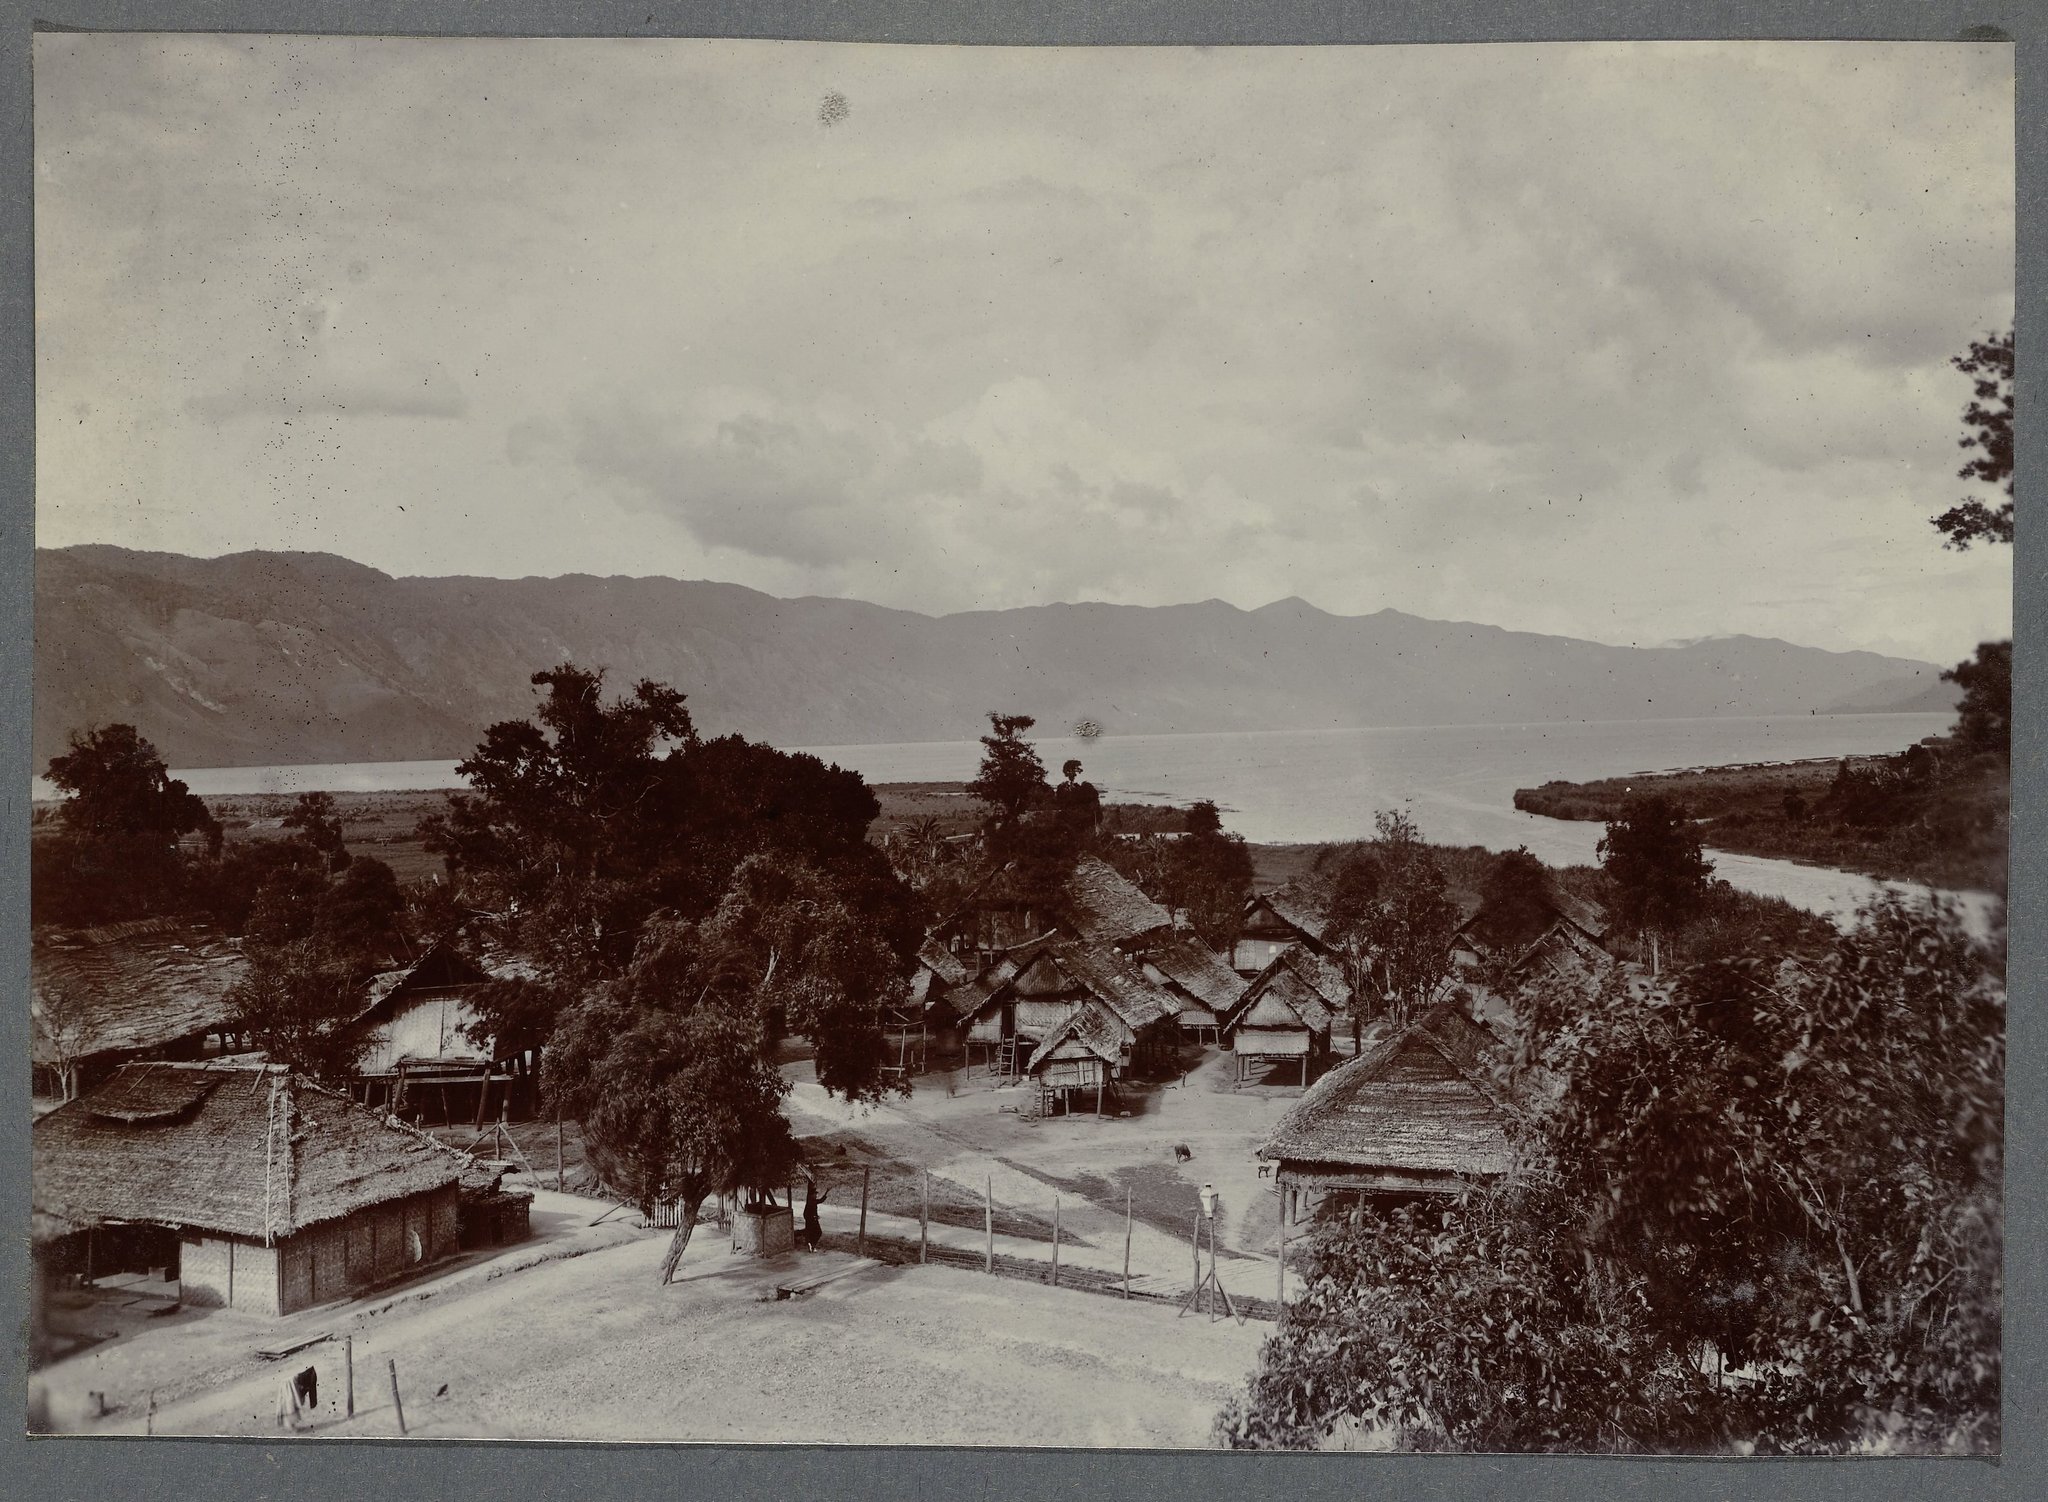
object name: photograph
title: Takengon aan het meer Laut Tawar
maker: Anonymous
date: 1903-1913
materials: photographic support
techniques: gelatin silver print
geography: north sumatra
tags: albertus dominicus laman trip, building activities, traffic by road or path with motor-vehicle, landscapes in tropical and sub-tropical regions, road, path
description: Na de expedities naar de Gajo- en Alaslanden o.l.v. Van Daalen (eerste tocht in 1901), werd hij in 1903 belast met voorbereiding van permanente vestiging van Nederlands gezag. Aanleg van een weg van de Noordkust naar het binnenland was hierbij van groot belang. Deze zgn. Gajoweg werd aangelegd tussen 1903 en 1914, van Bireuen aan de kust naar Takinguen aan het bergmeer Danau Lauttawar, totale lengte 104 km.